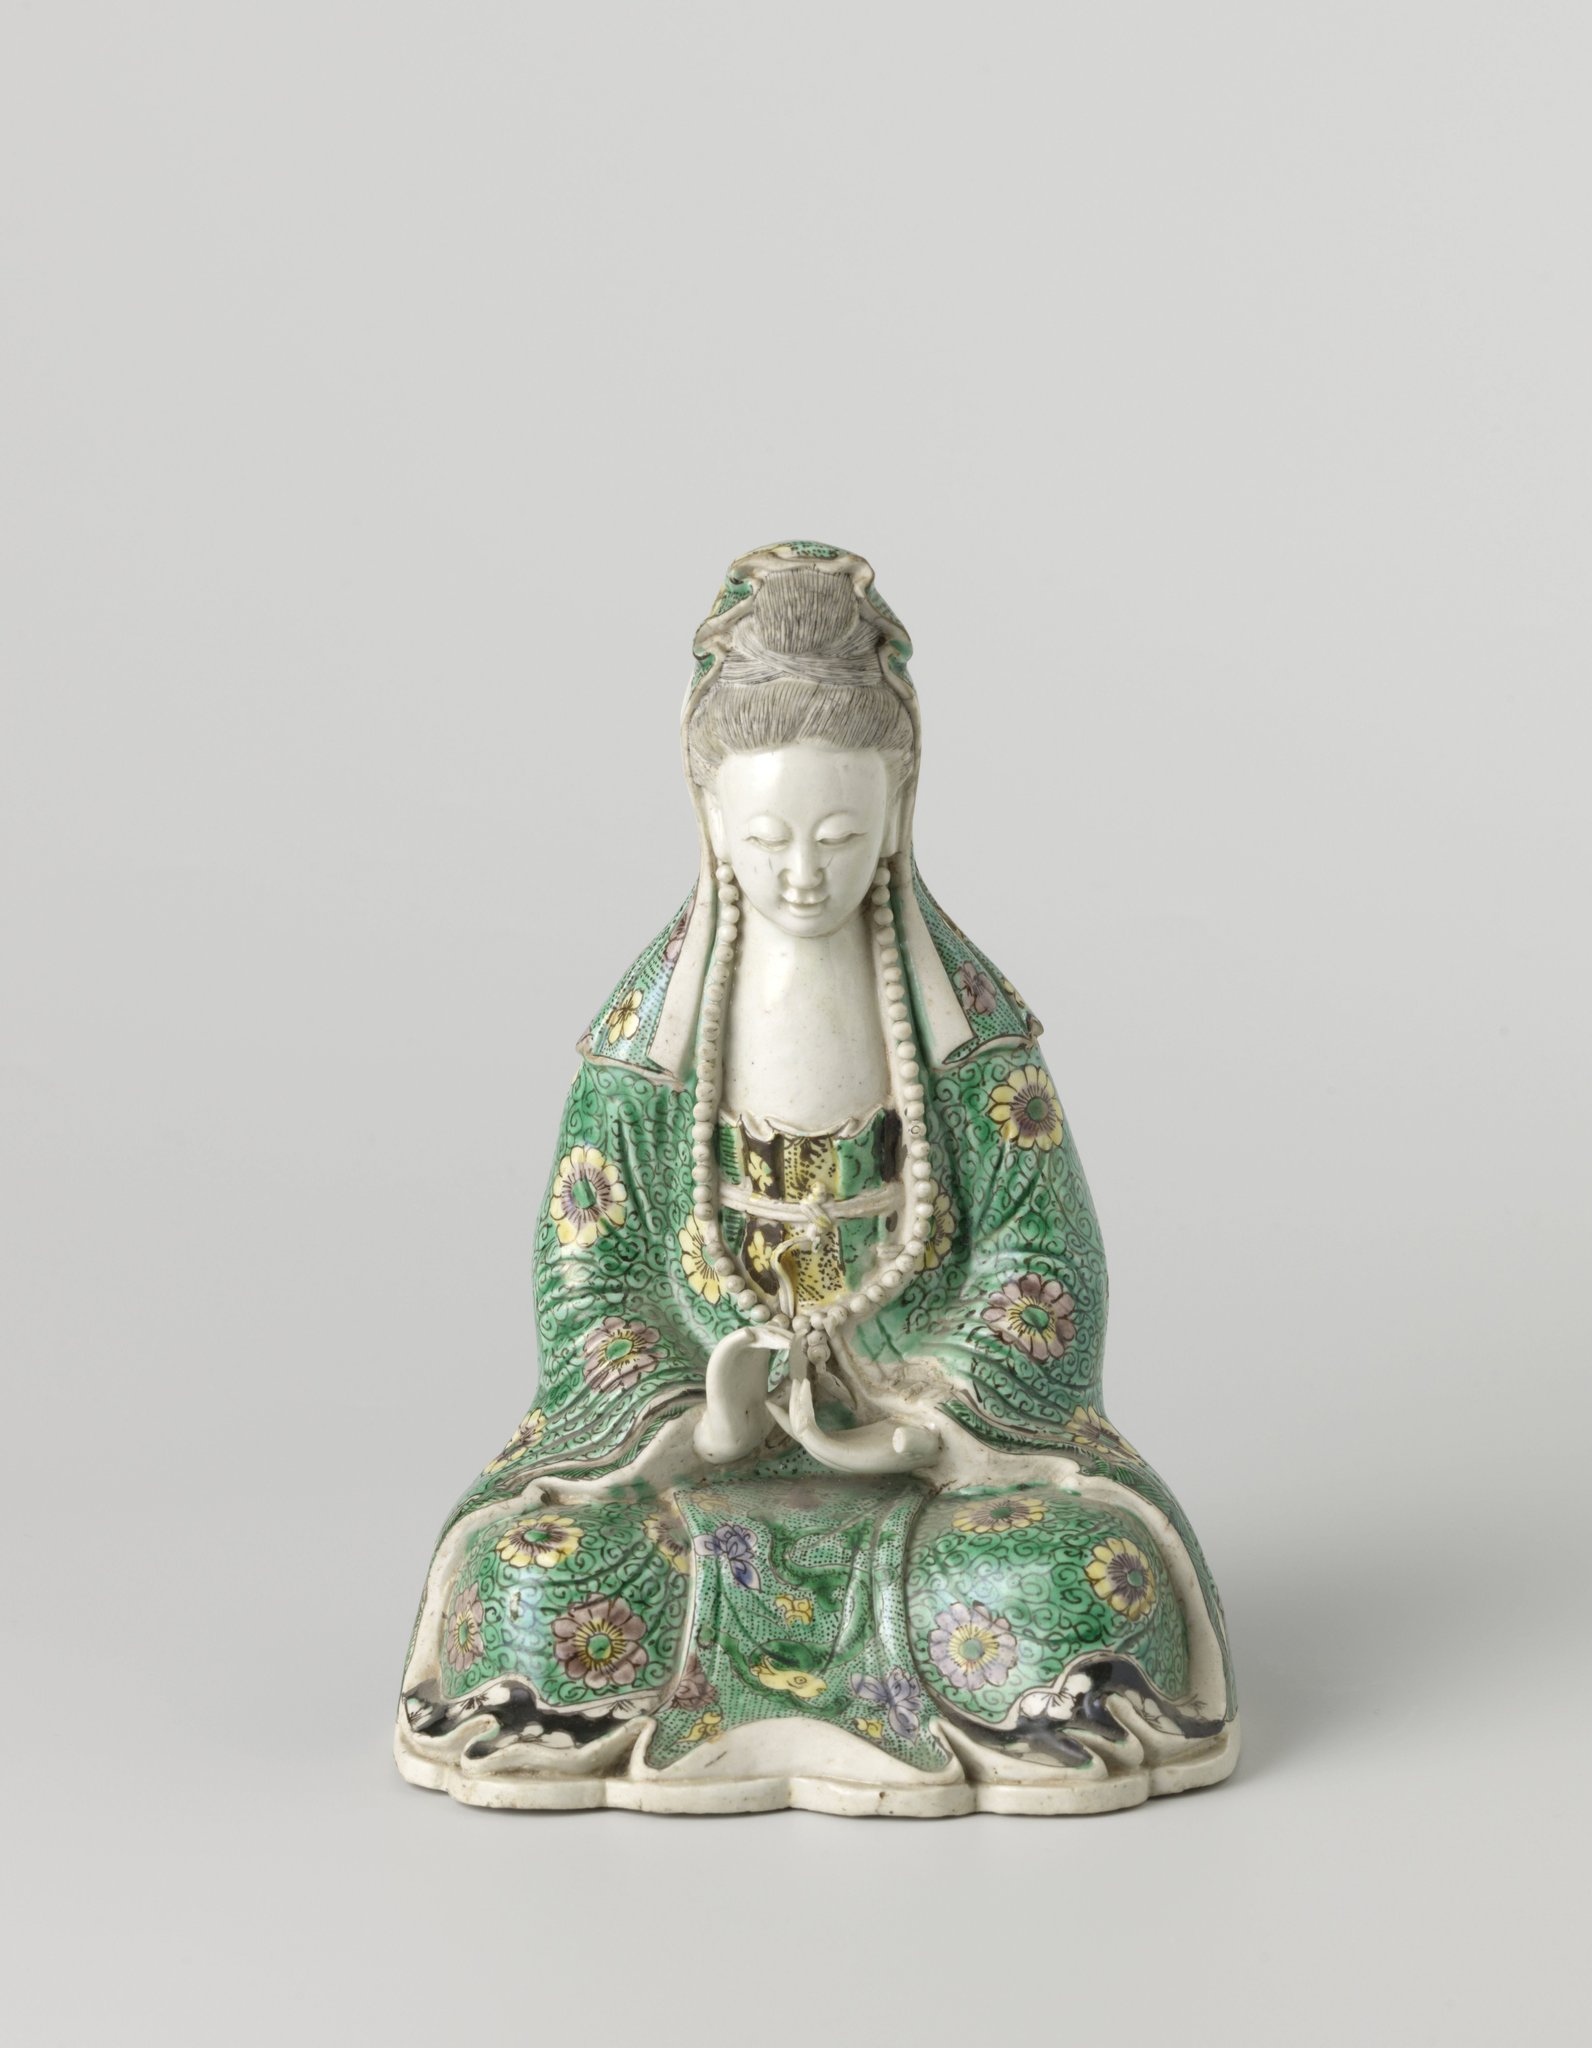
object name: figure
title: Guanyin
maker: Anonymous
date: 1800-1899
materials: glaze, paint, porcelain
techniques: firing, forming, vitrification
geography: china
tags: guan yin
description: In contrast to the conventional Guanyin in white attire, this figure is adorned in colourful green, yellow, purple, and black floral patterns in the so-called famille verte glaze palette. The entirely white face creates a marked contrast with the decoration of the clothing.